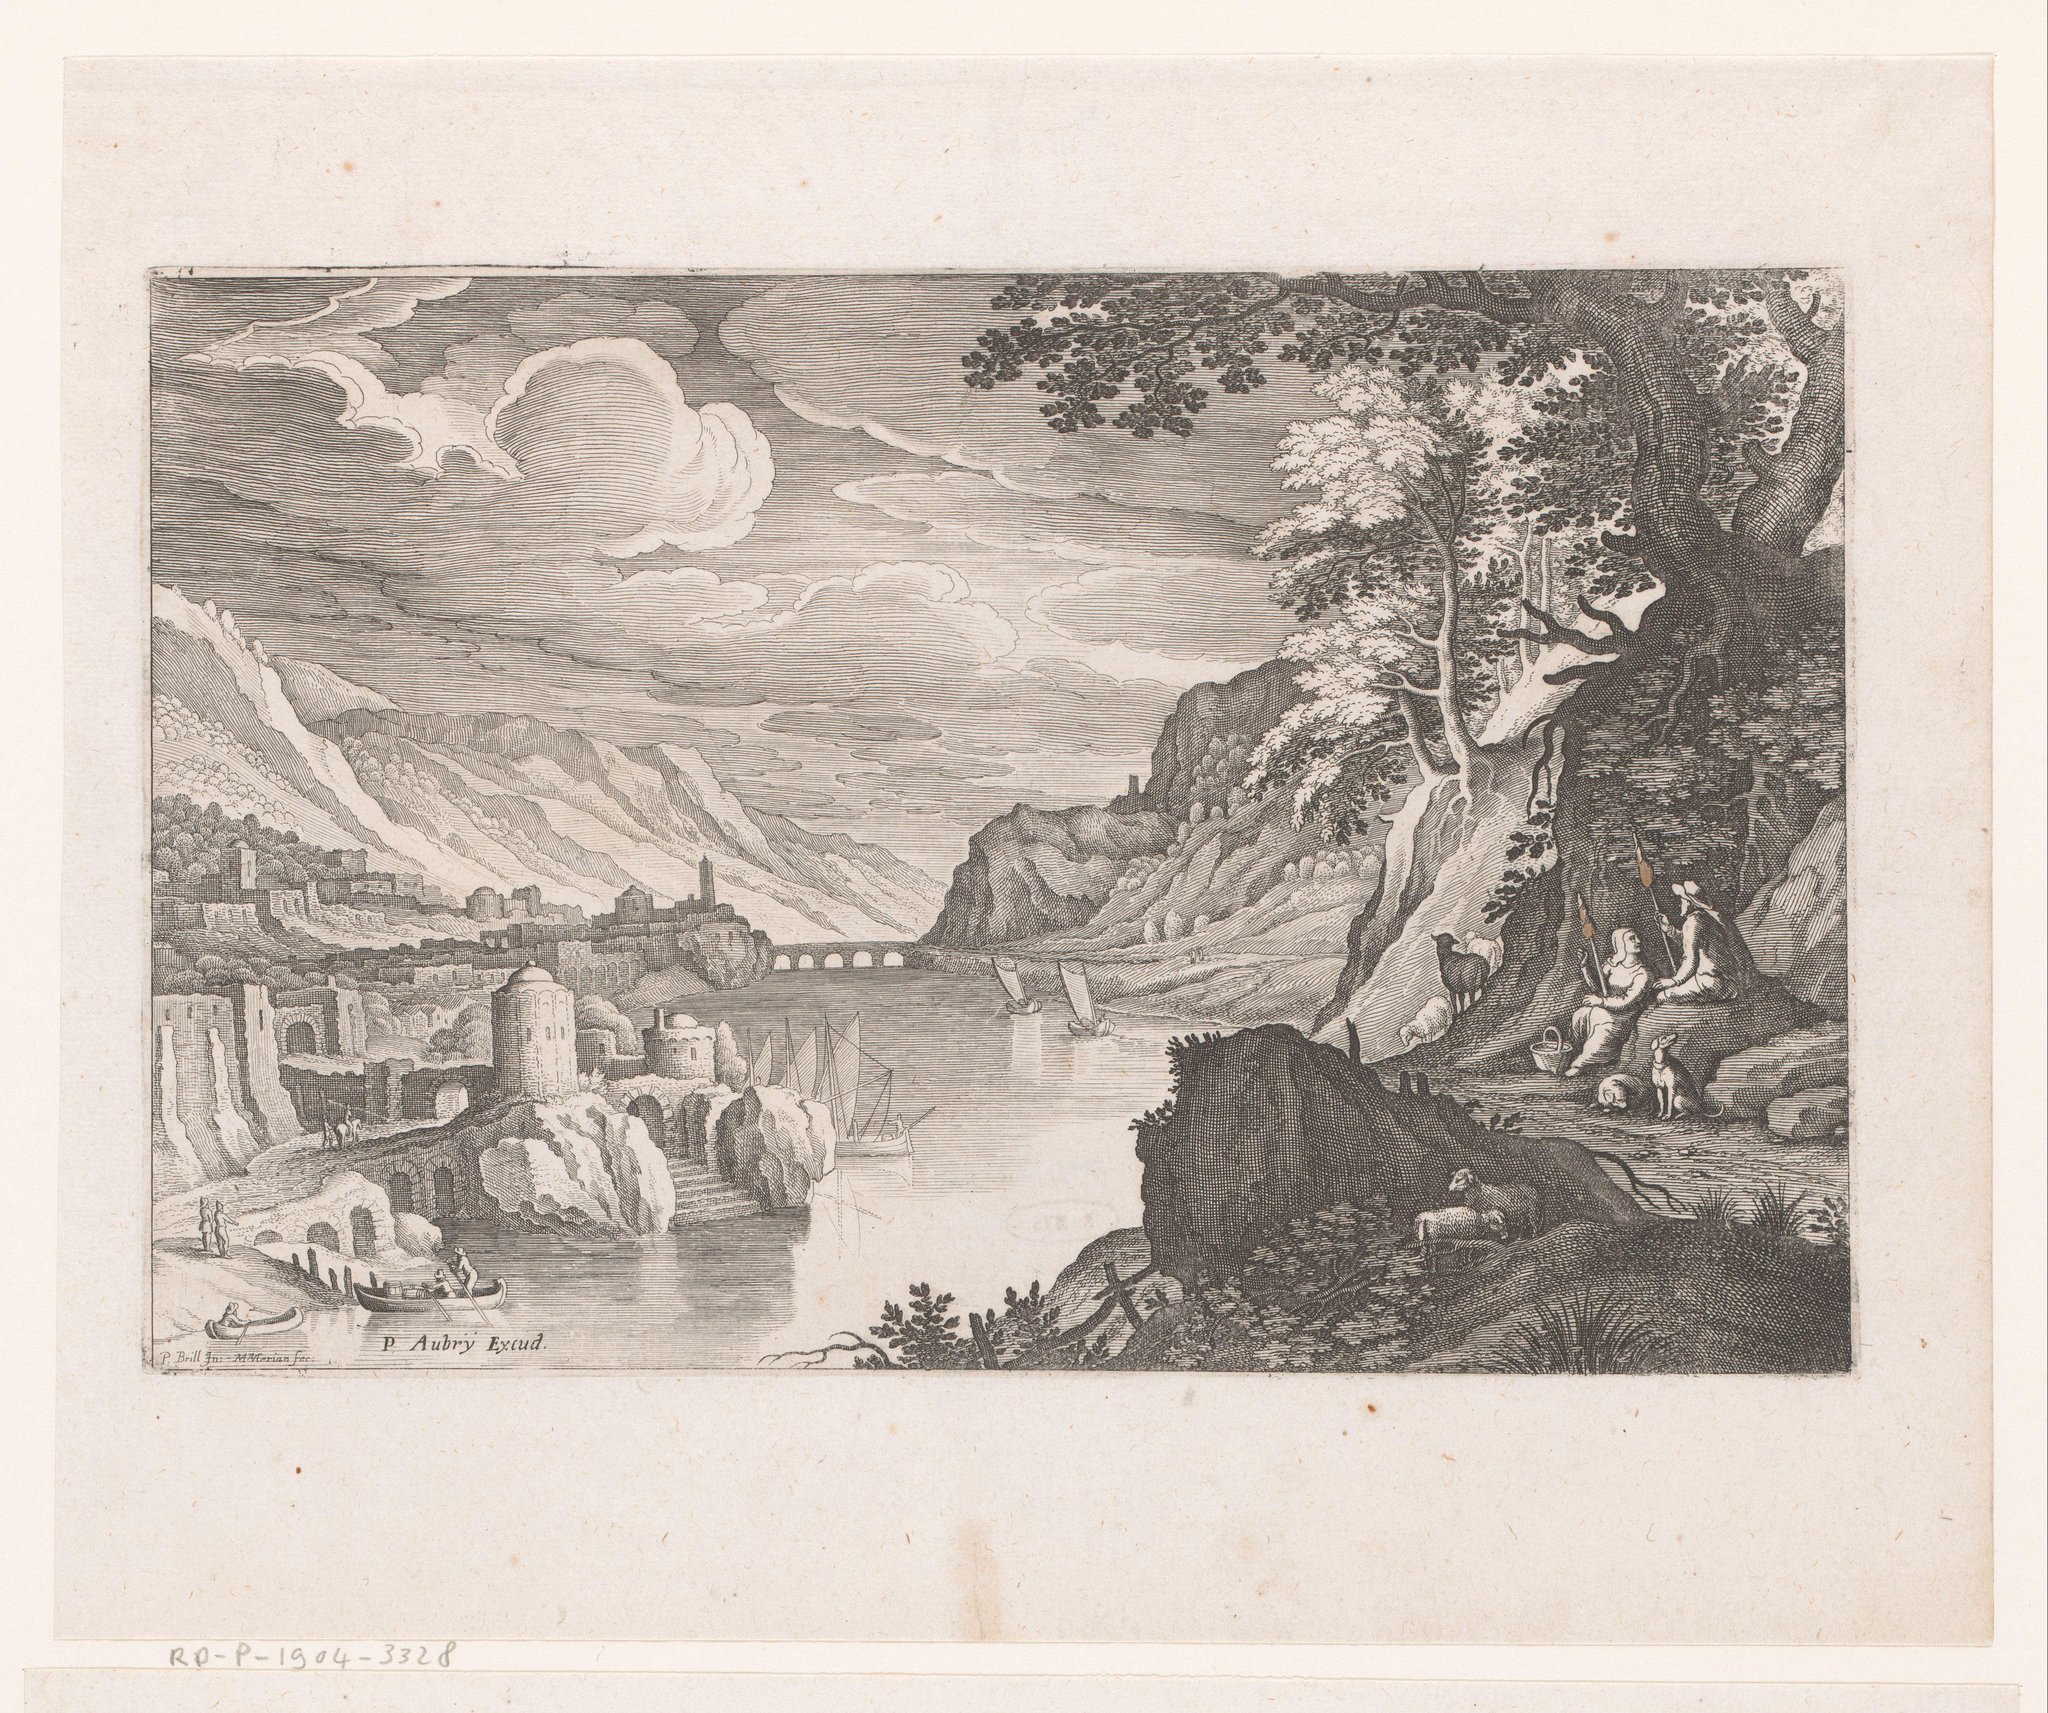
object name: print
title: Ruïne van een stad met rivier in berglandschap met spinnende herders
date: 1603-1650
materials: paper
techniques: etching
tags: spindle, river (+ landscape with figures, staffage), landscape with ruins (+ city(-scape) with figures, staffage), herd, flock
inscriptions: collector's mark: Lugt 2228